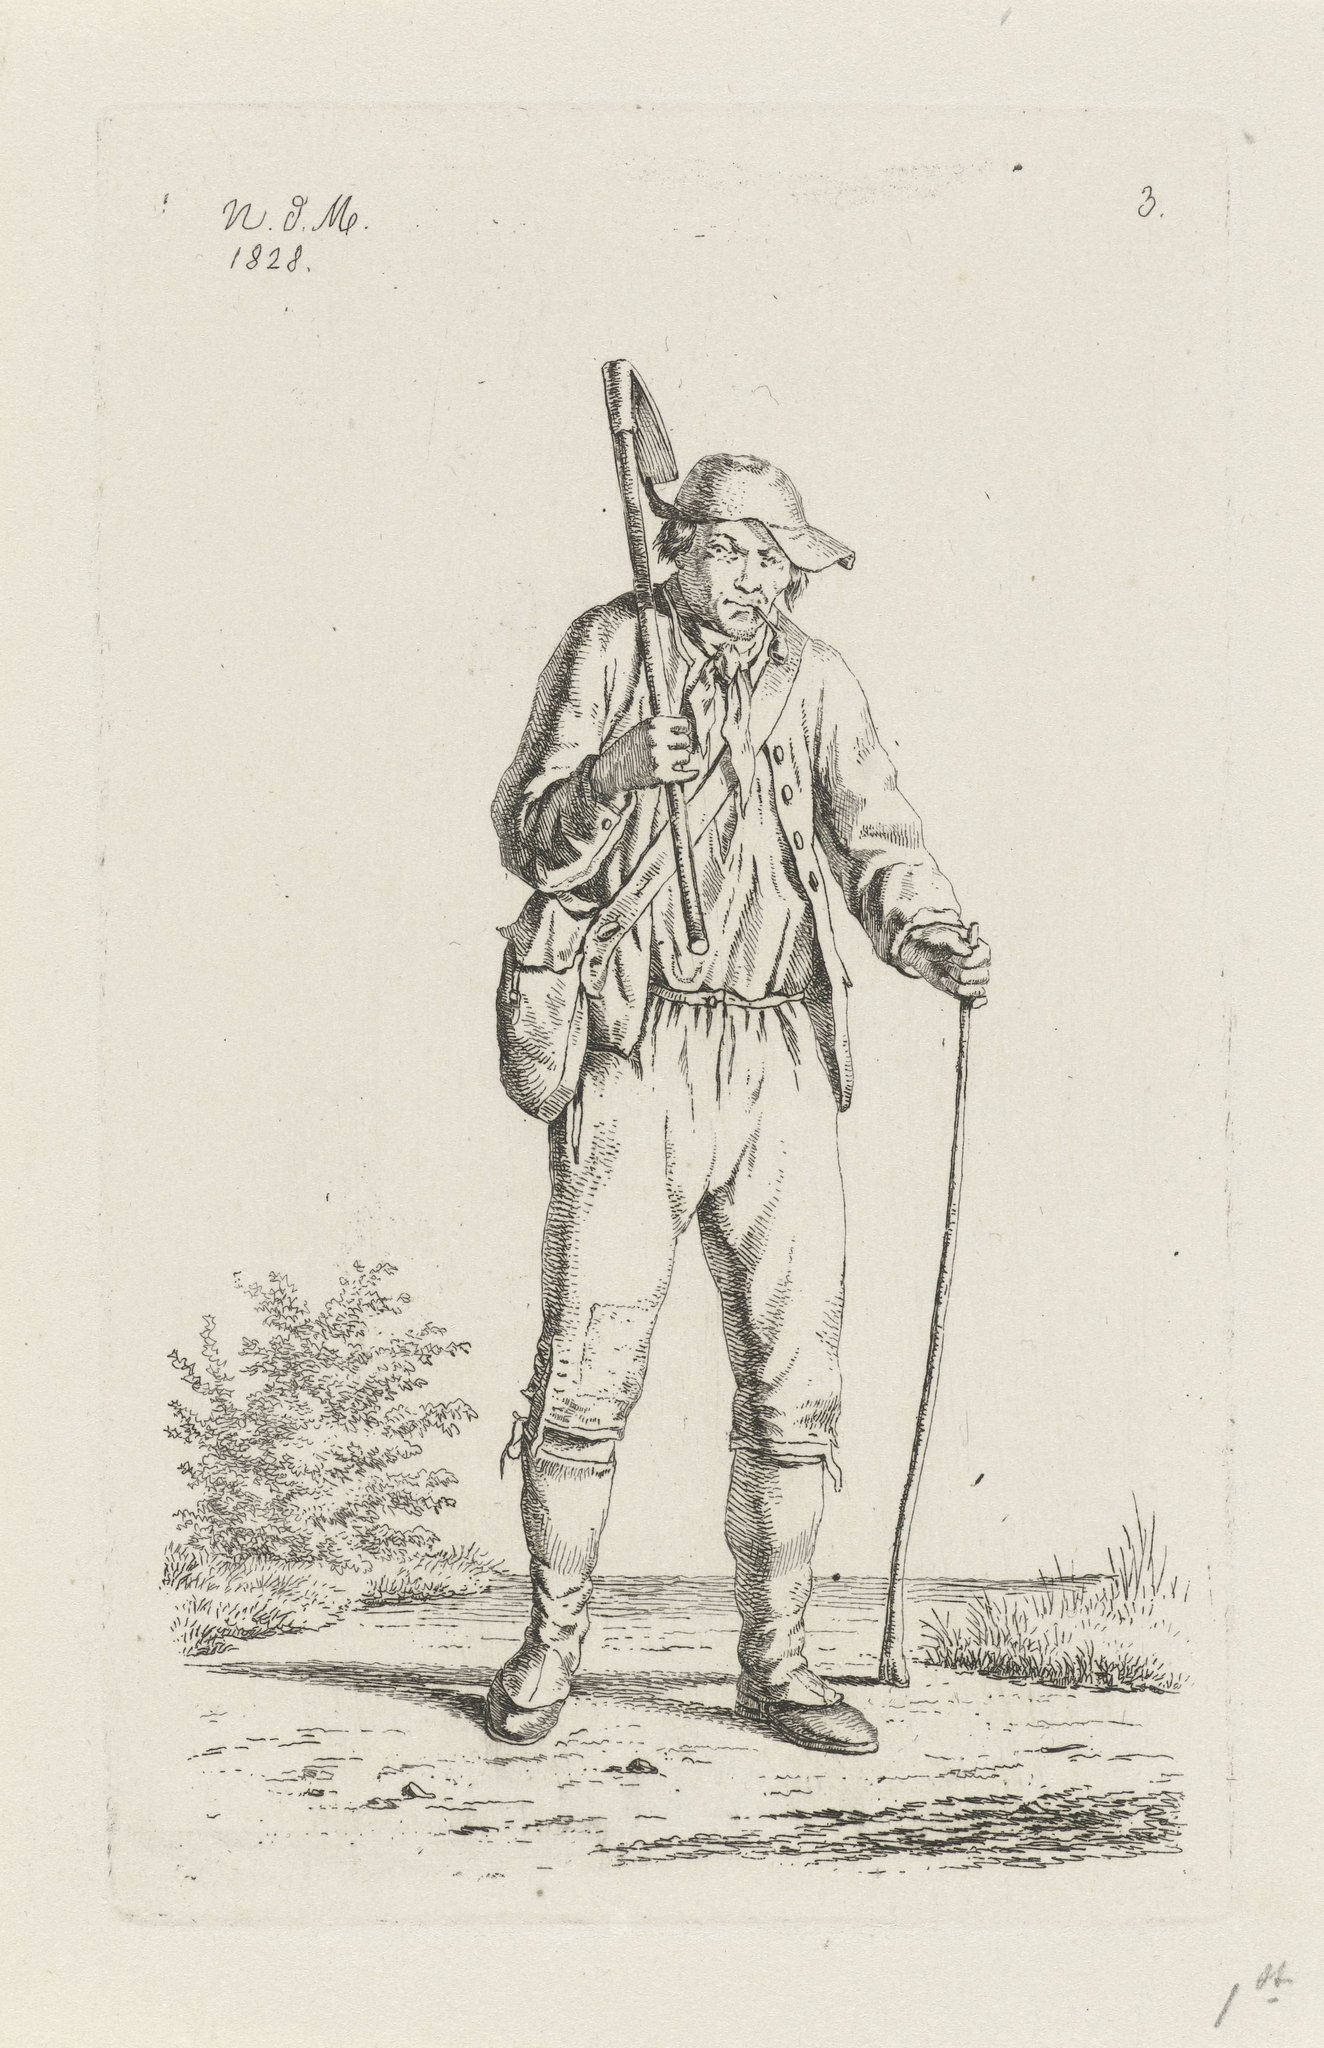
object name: print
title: Boeren en boerinnen uit het Verenigd Koninkrijk der Nederlanden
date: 1828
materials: paper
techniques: etching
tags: gardening-tools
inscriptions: collector's mark: Lugt 2228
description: Staande boer uit de Ardennen met een schoffel over zijn schouder en een stok in zijn hand. Proefdruk van de derde prent uit een serie van zes prenten met voorstellingen van verschillende boeren en boerinnen uit het Verenigd Koninkrijk der Nederlanden.